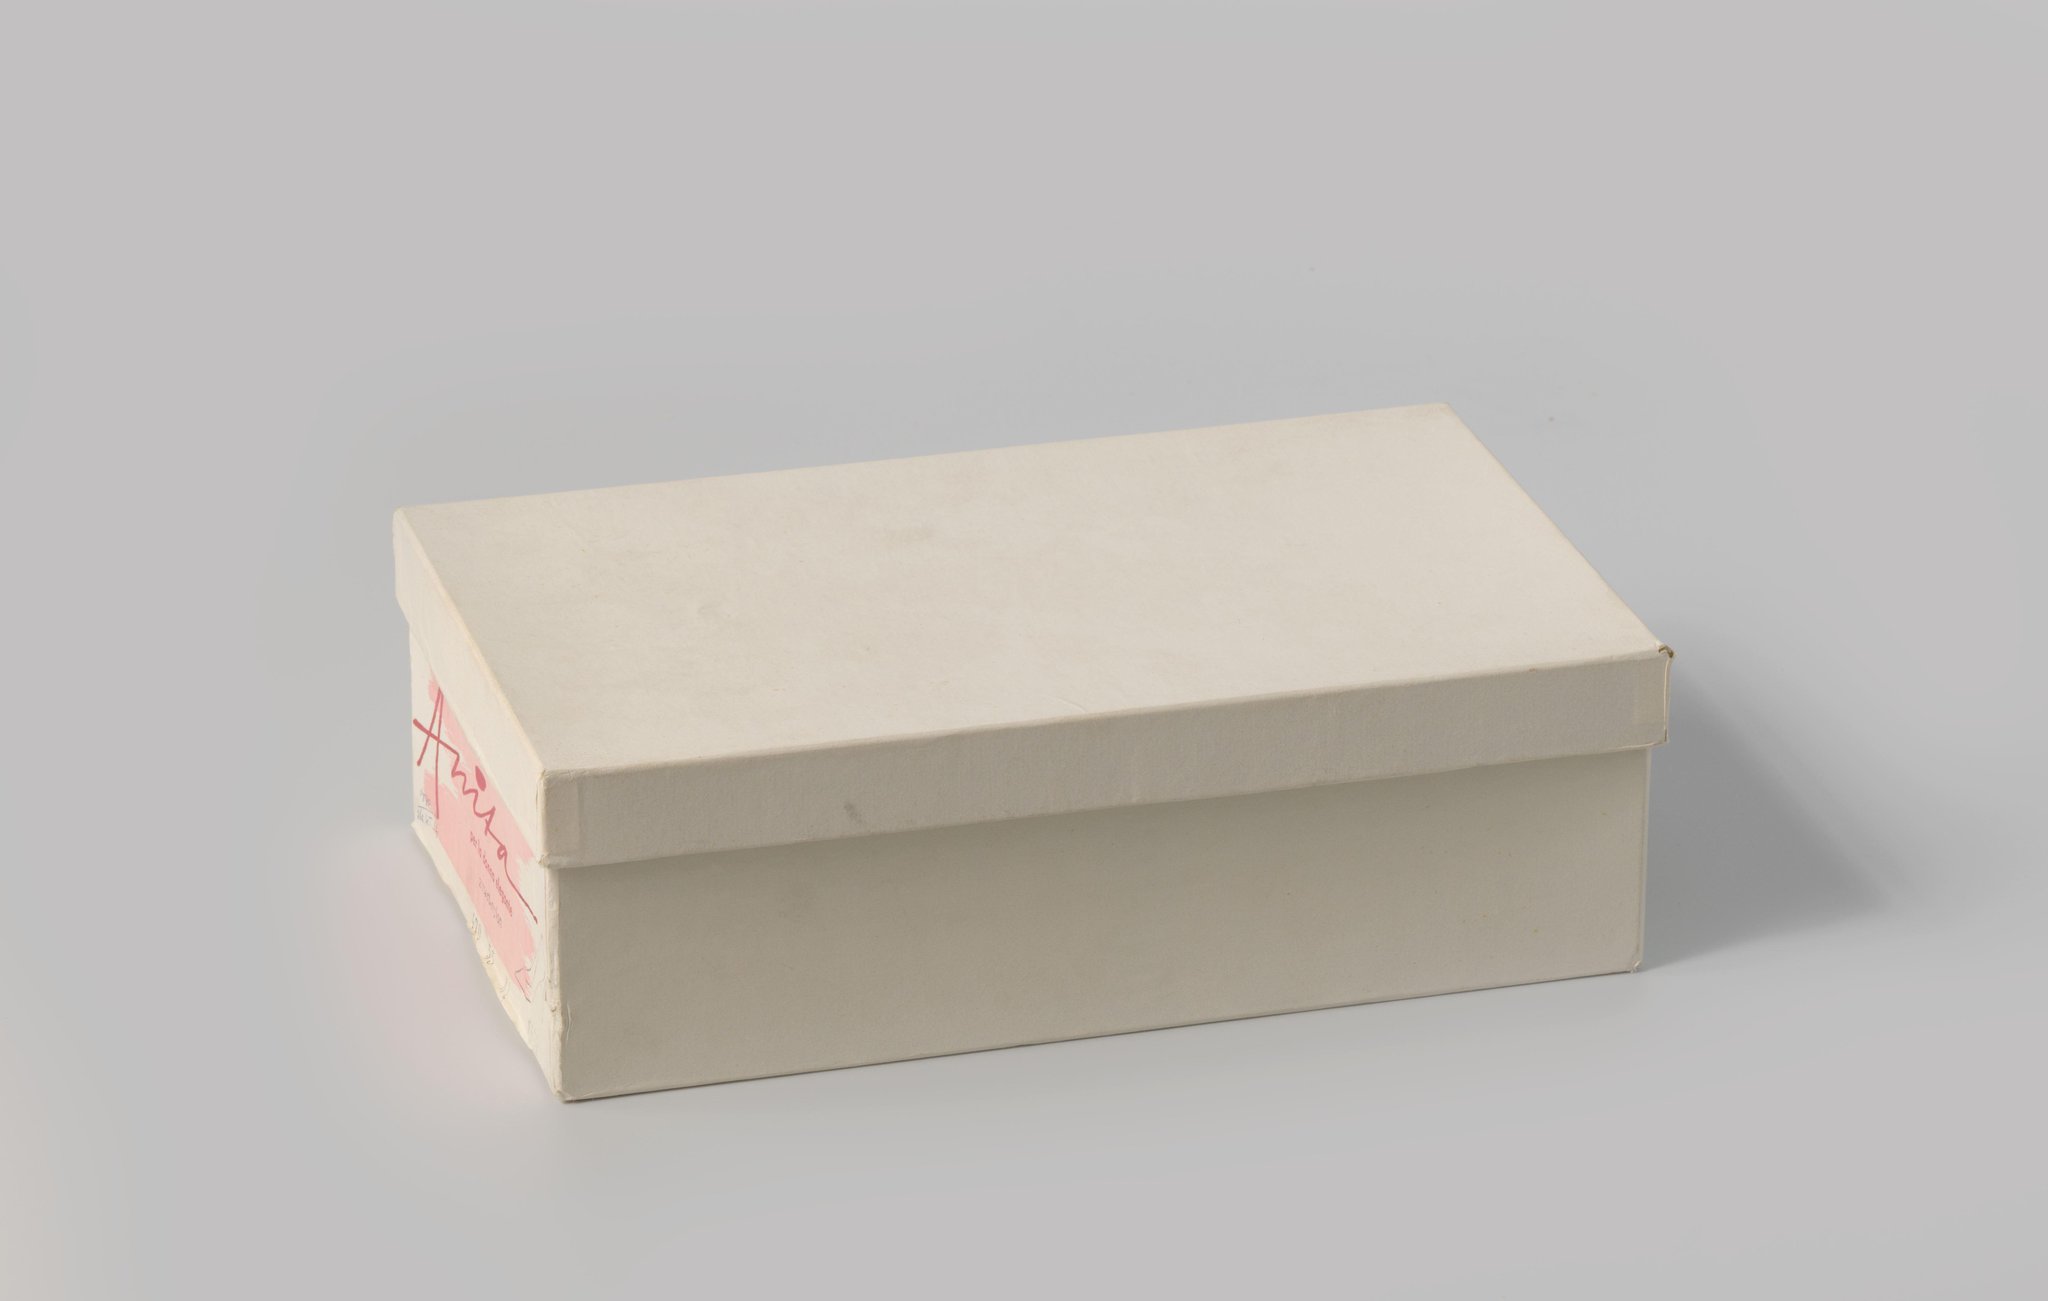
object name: avondschoen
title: Witte kartonnen schoenendoos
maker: anita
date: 1965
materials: cardboard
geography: italy